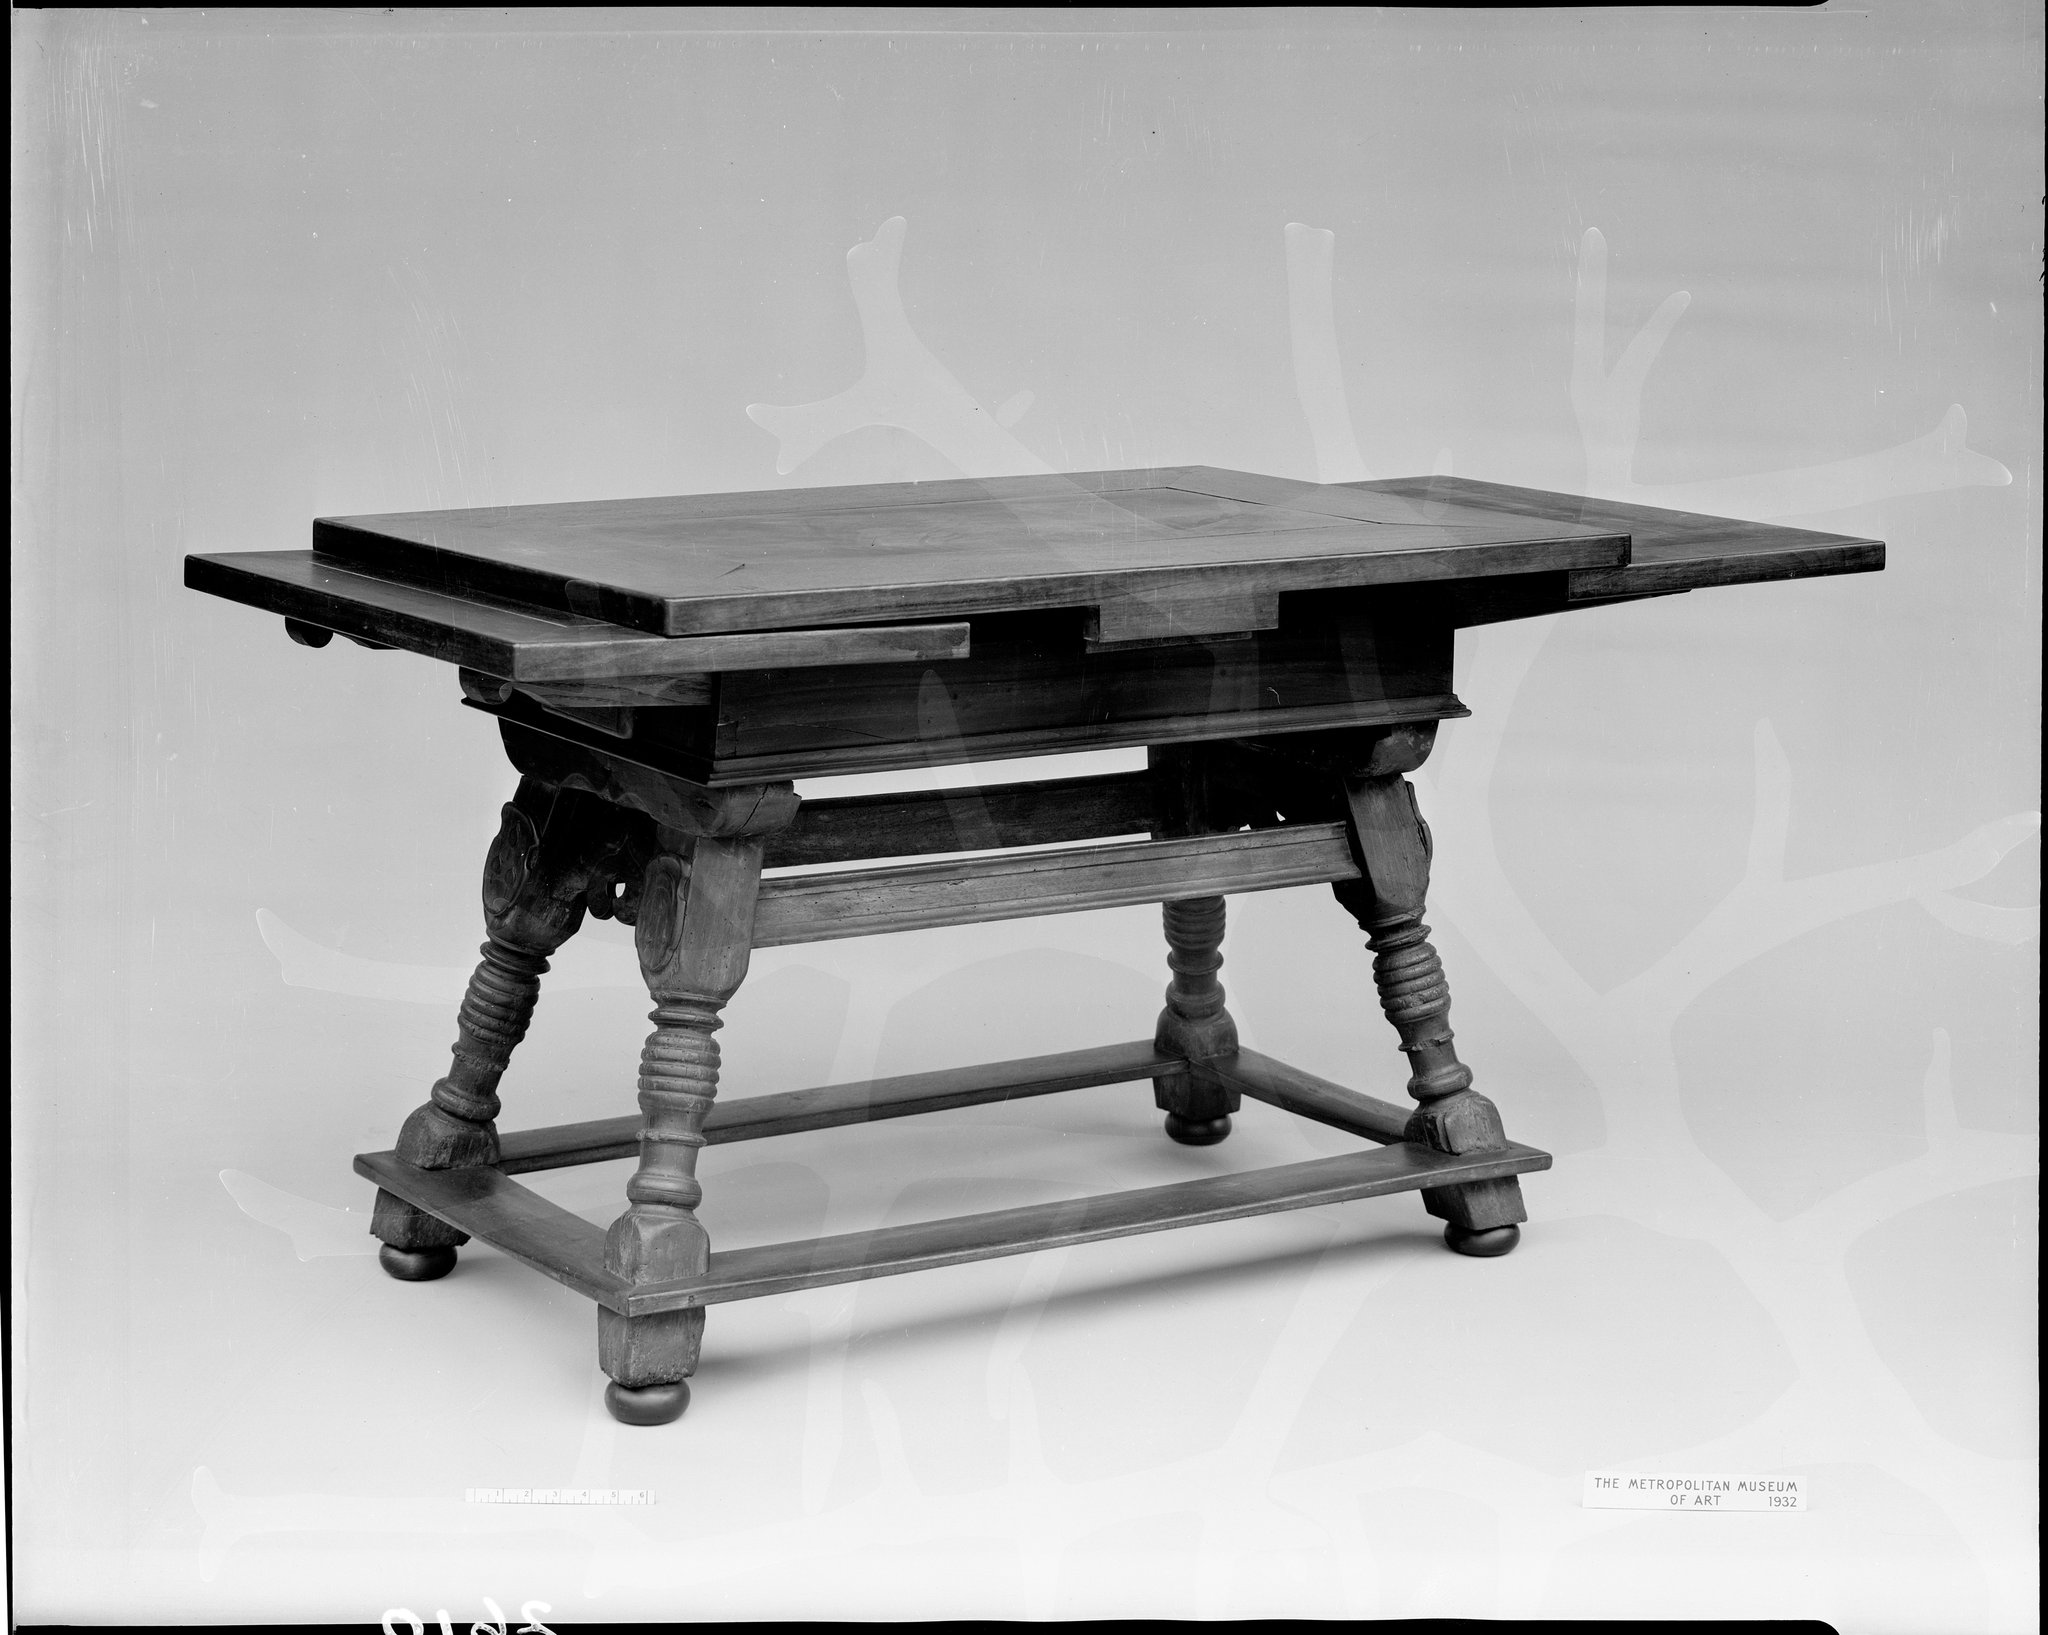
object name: draw top table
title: Draw-top table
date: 1601-1700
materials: wood